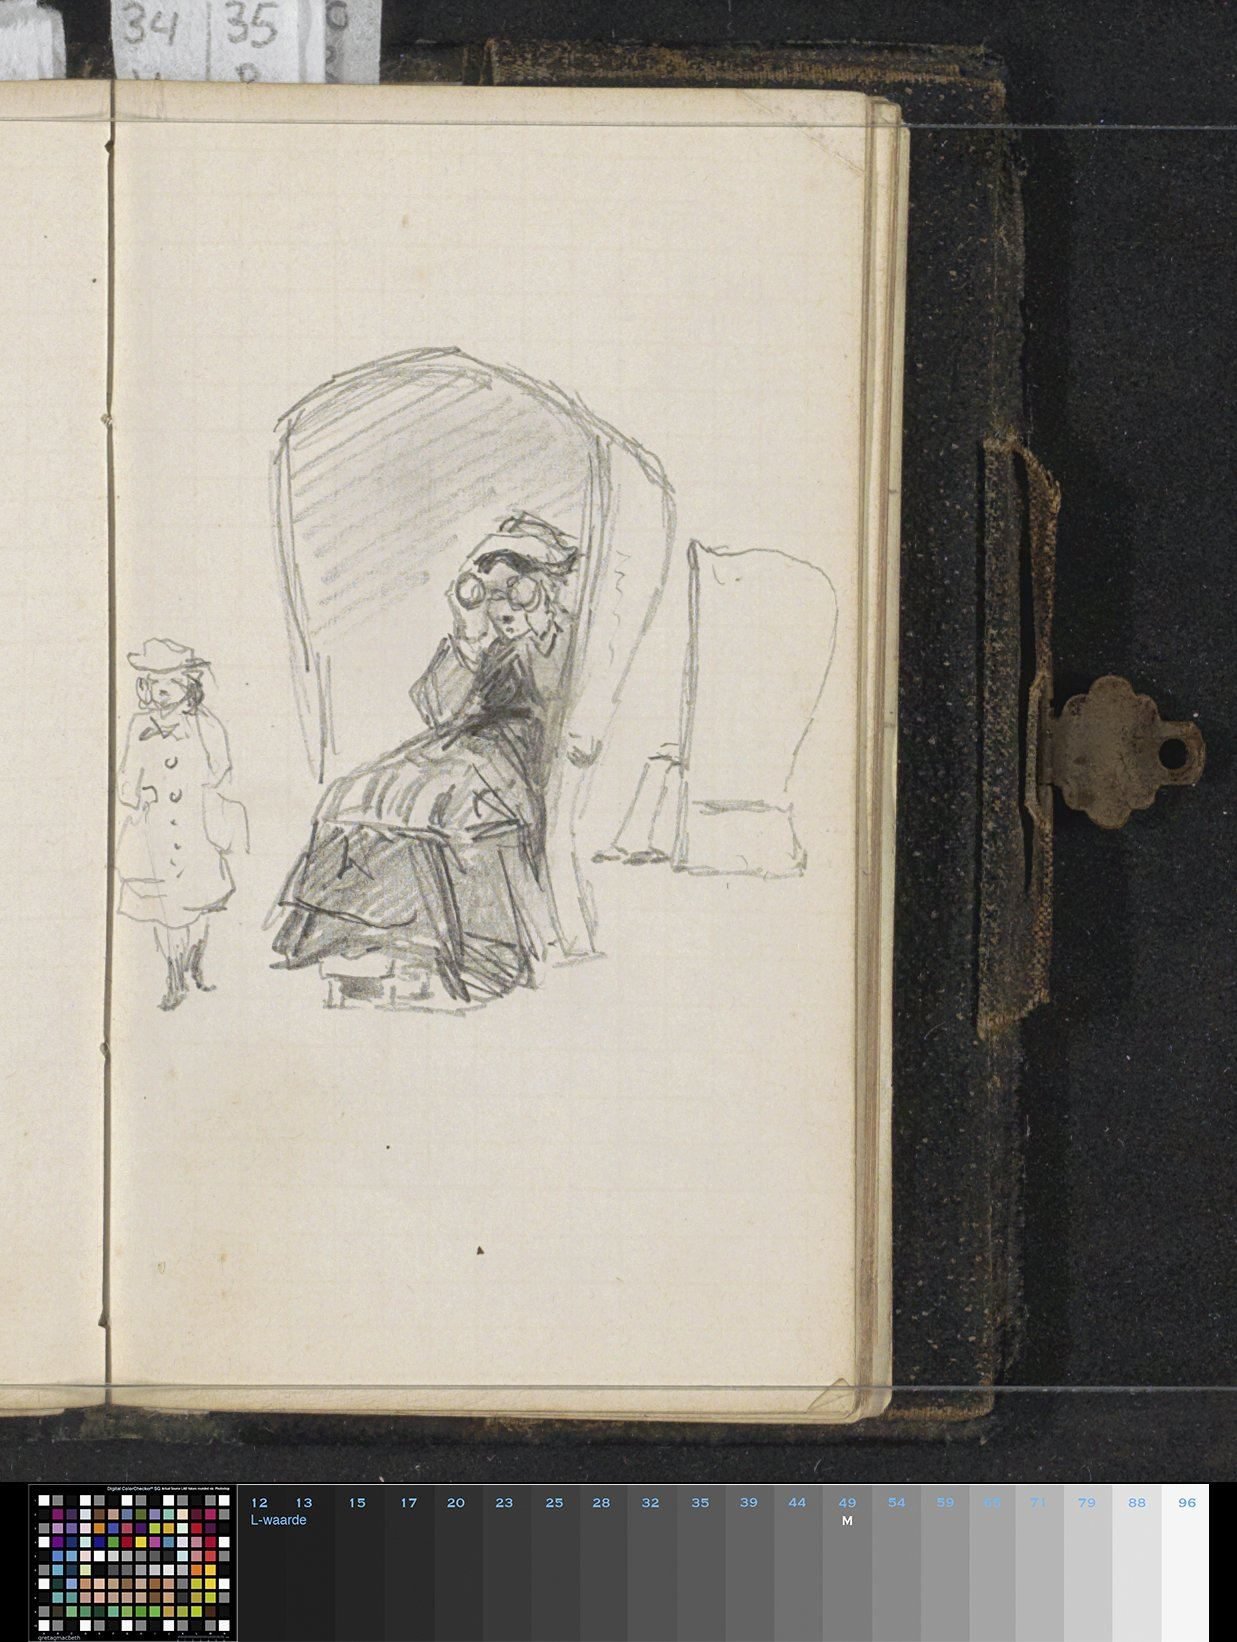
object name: sketchbook leaf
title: Vrouw met een verrekijker in een strandstoel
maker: jan willem van borselen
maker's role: draughtsman, print maker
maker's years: 1825-1892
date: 1868-1887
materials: pencil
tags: sitting figure - aa - female human figure, chair, binoculars, spy-glass, etc.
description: Blad 33 recto uit een schetsboek met 51 bladen.